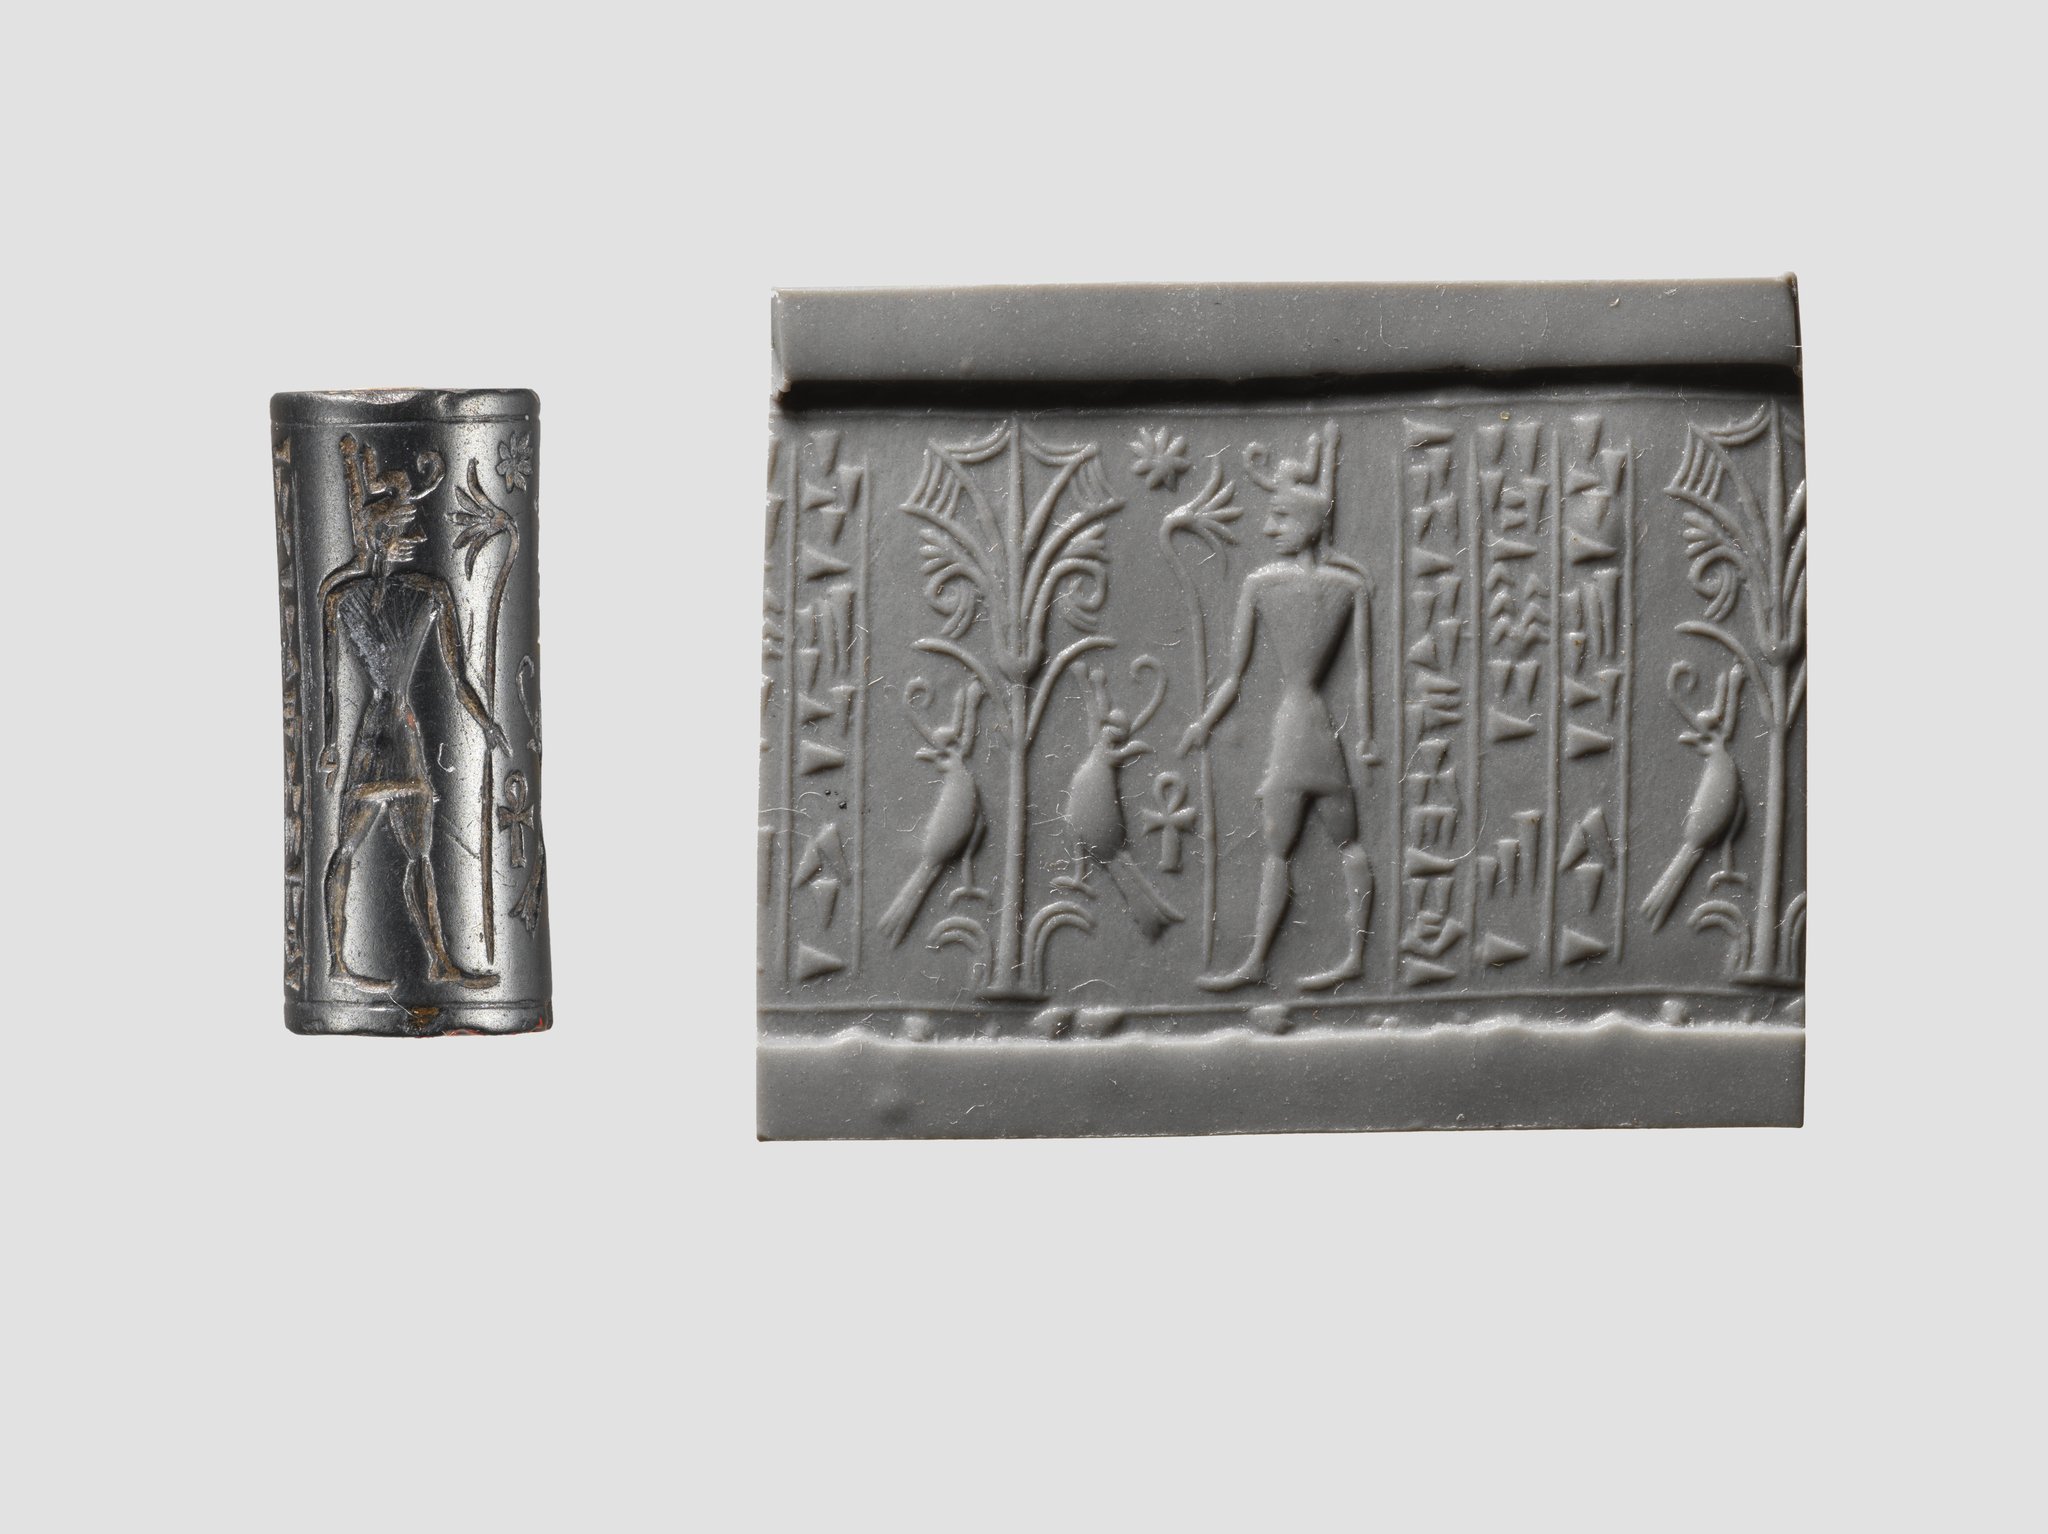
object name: cylinder seal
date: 2000-1668 BCE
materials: mineral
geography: syria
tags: birds